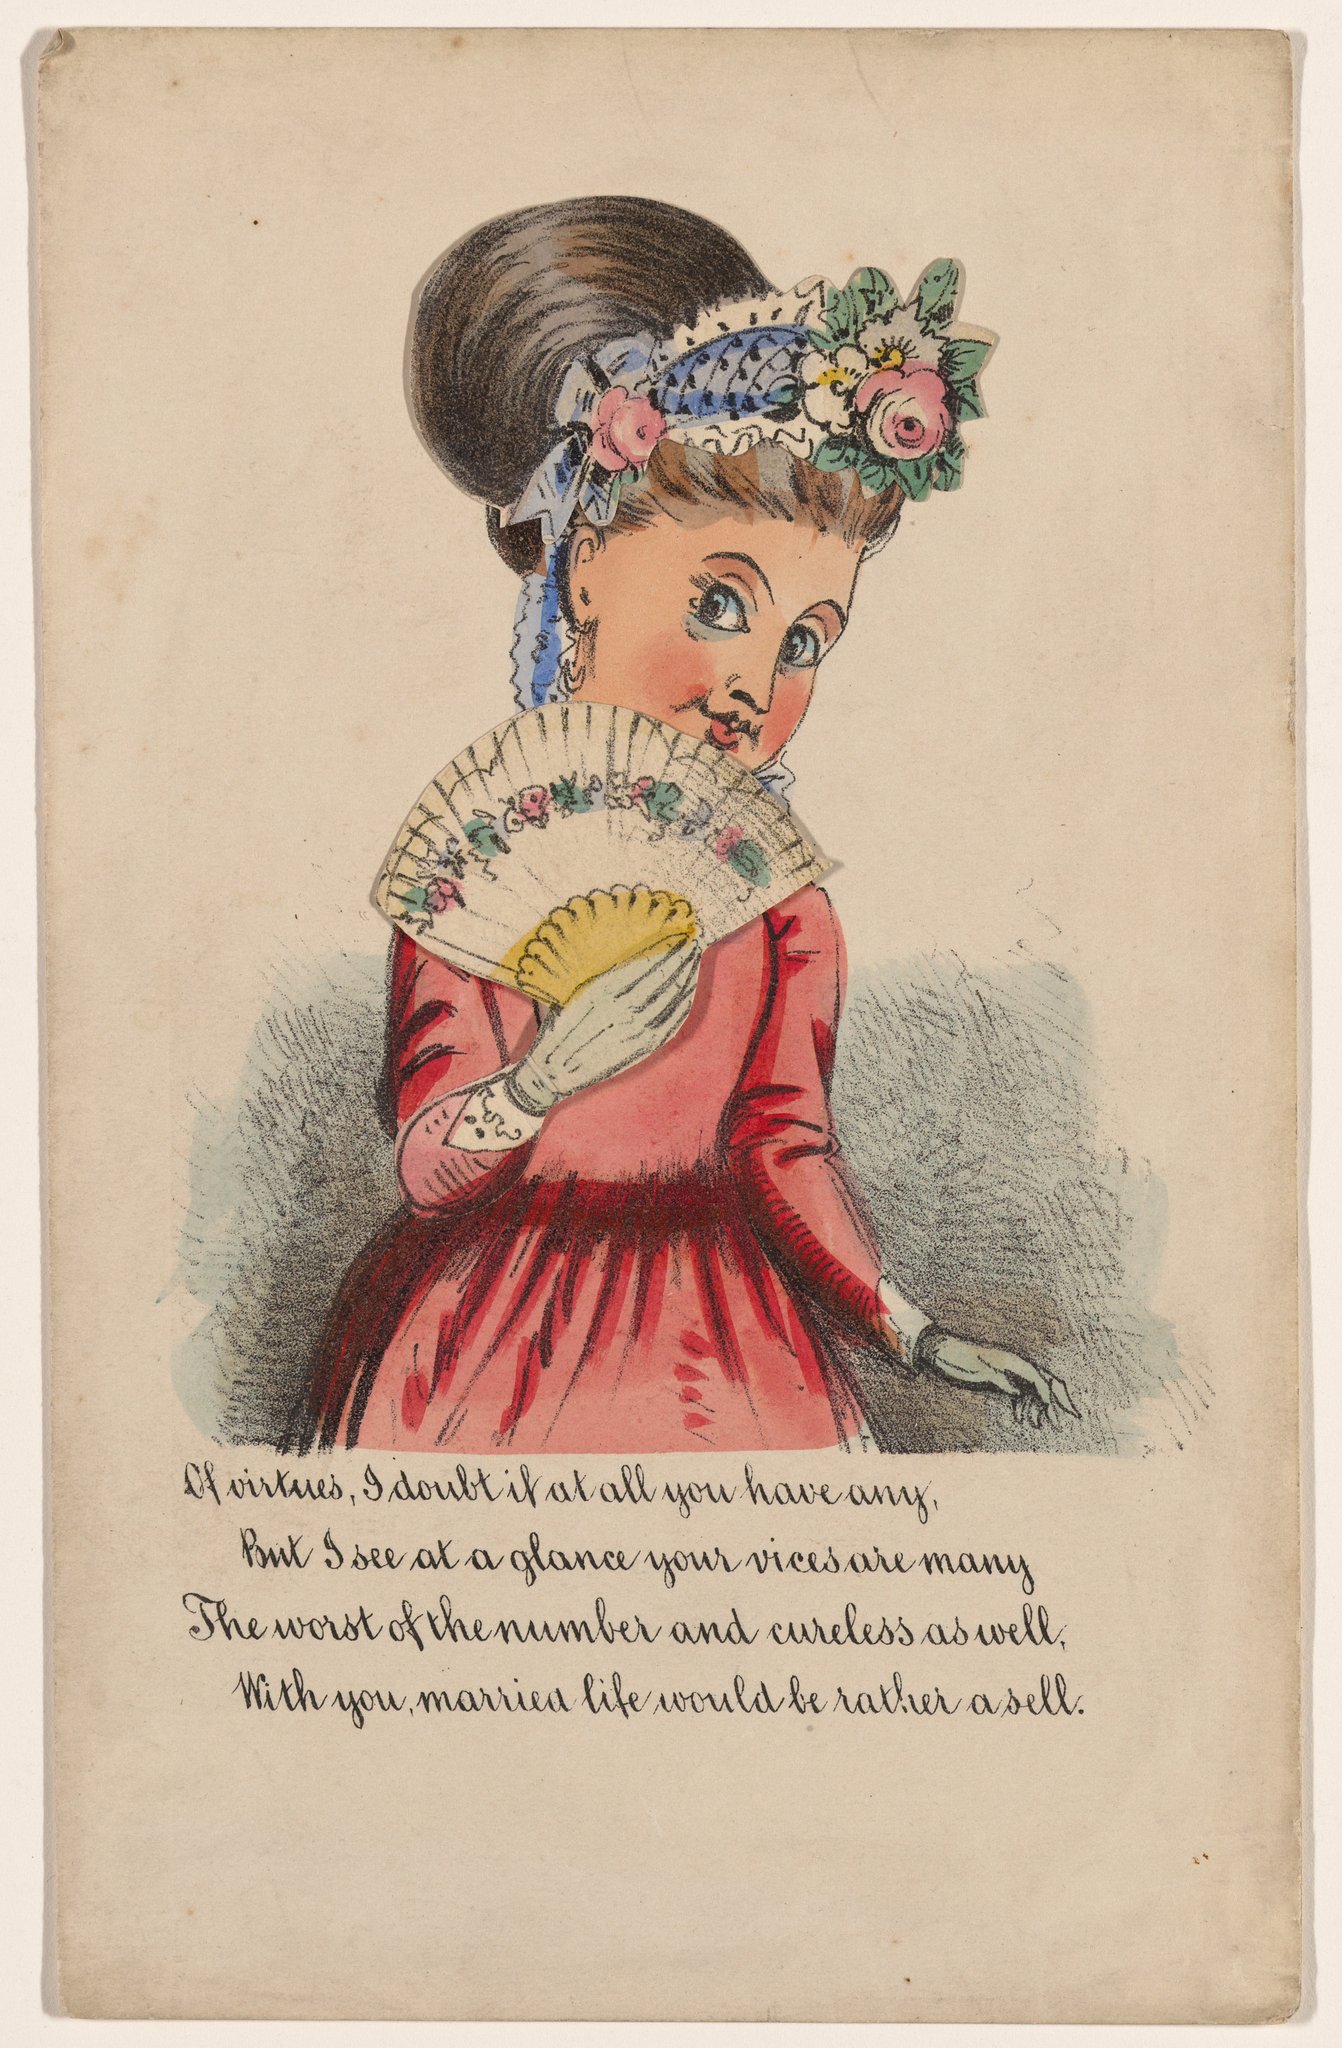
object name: valentine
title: Comic Valentine (shy woman)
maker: Anonymous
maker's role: artist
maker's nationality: british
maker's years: 1800-1899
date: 1860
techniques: hand coloring, lithograph